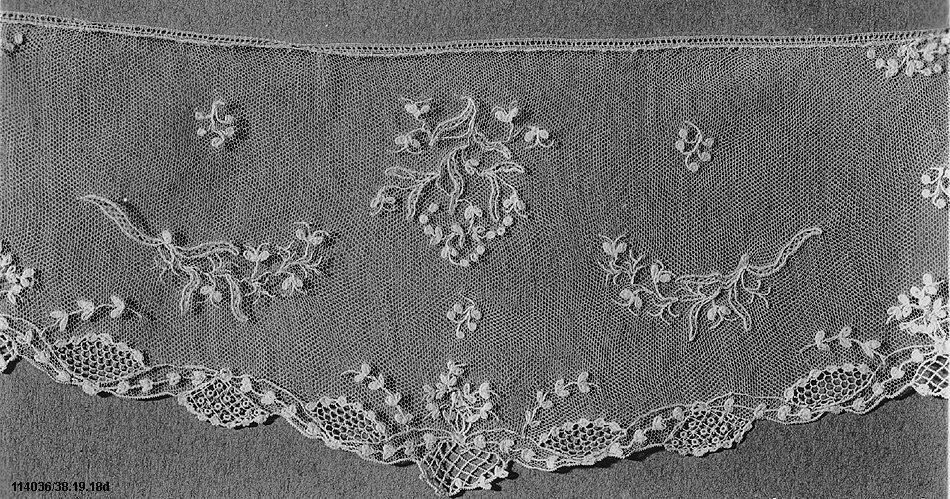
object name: sleeve trimming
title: Sleeve ruffle (Engageante) (one of a pair)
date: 1774-1793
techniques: lace